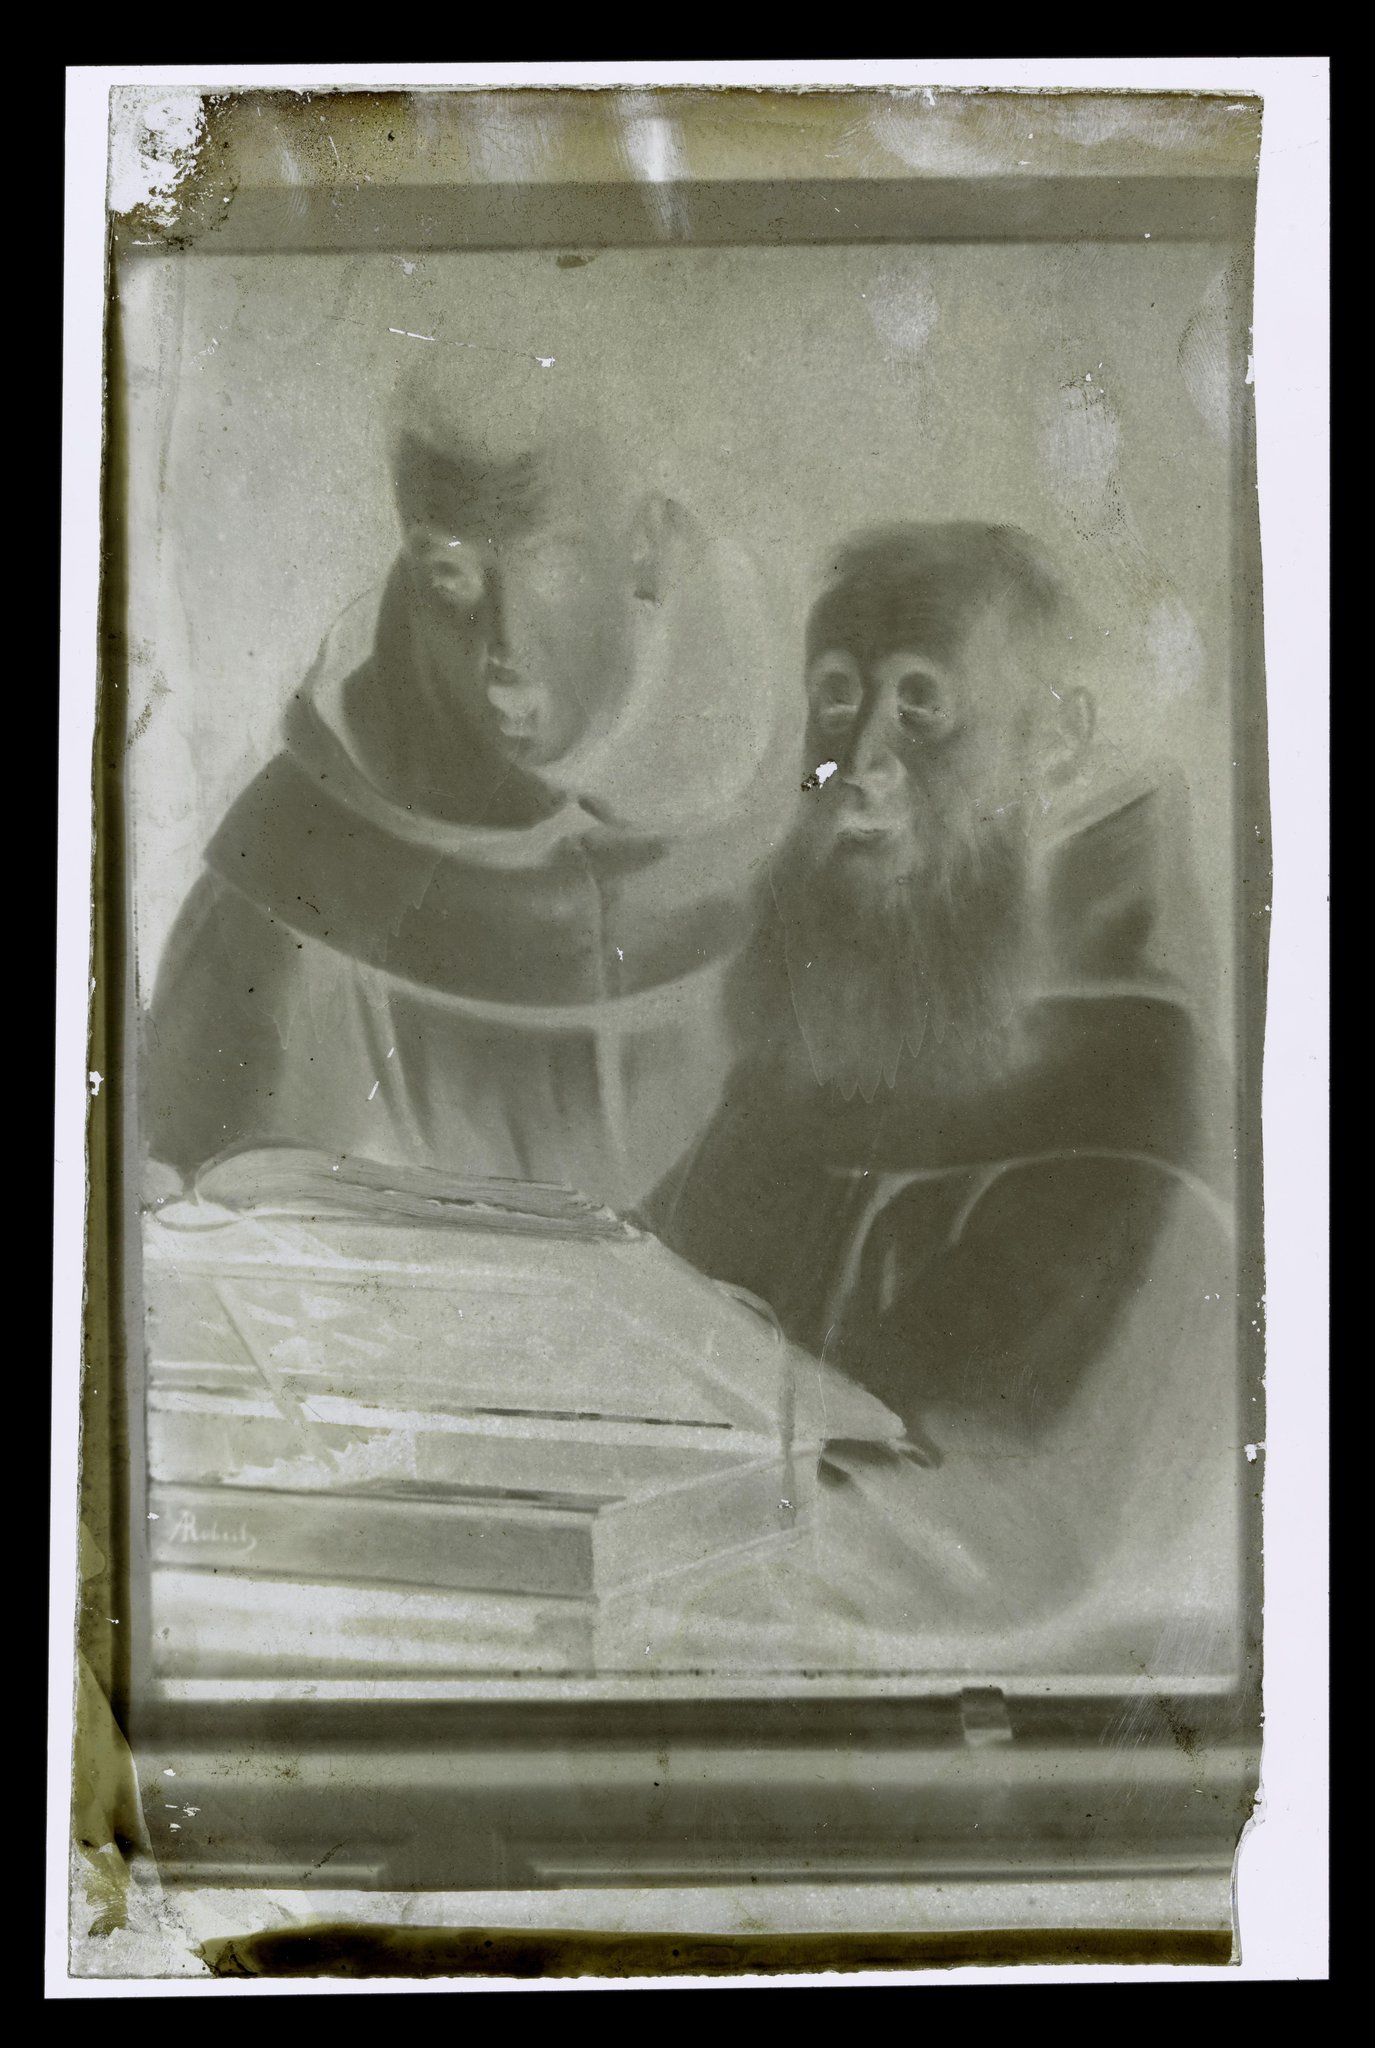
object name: glasnegatief, glasplaatnegatief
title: Fotoreproductie van een schilderij van twee geestelijken bij een boek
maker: laurens lodewijk kleijn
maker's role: draughtsman, painter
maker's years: 1826-1909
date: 1865-1900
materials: glass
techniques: collodion process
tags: organization, functionaries and dignitaries in roman catholic church; clergy in general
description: Onderdeel van een groep glasnegatieven uit de nalatenschap van de schilder Laurens Lodewijk Kleijn, met stillevens, portretten, zelfportretten en kunstreproducties.